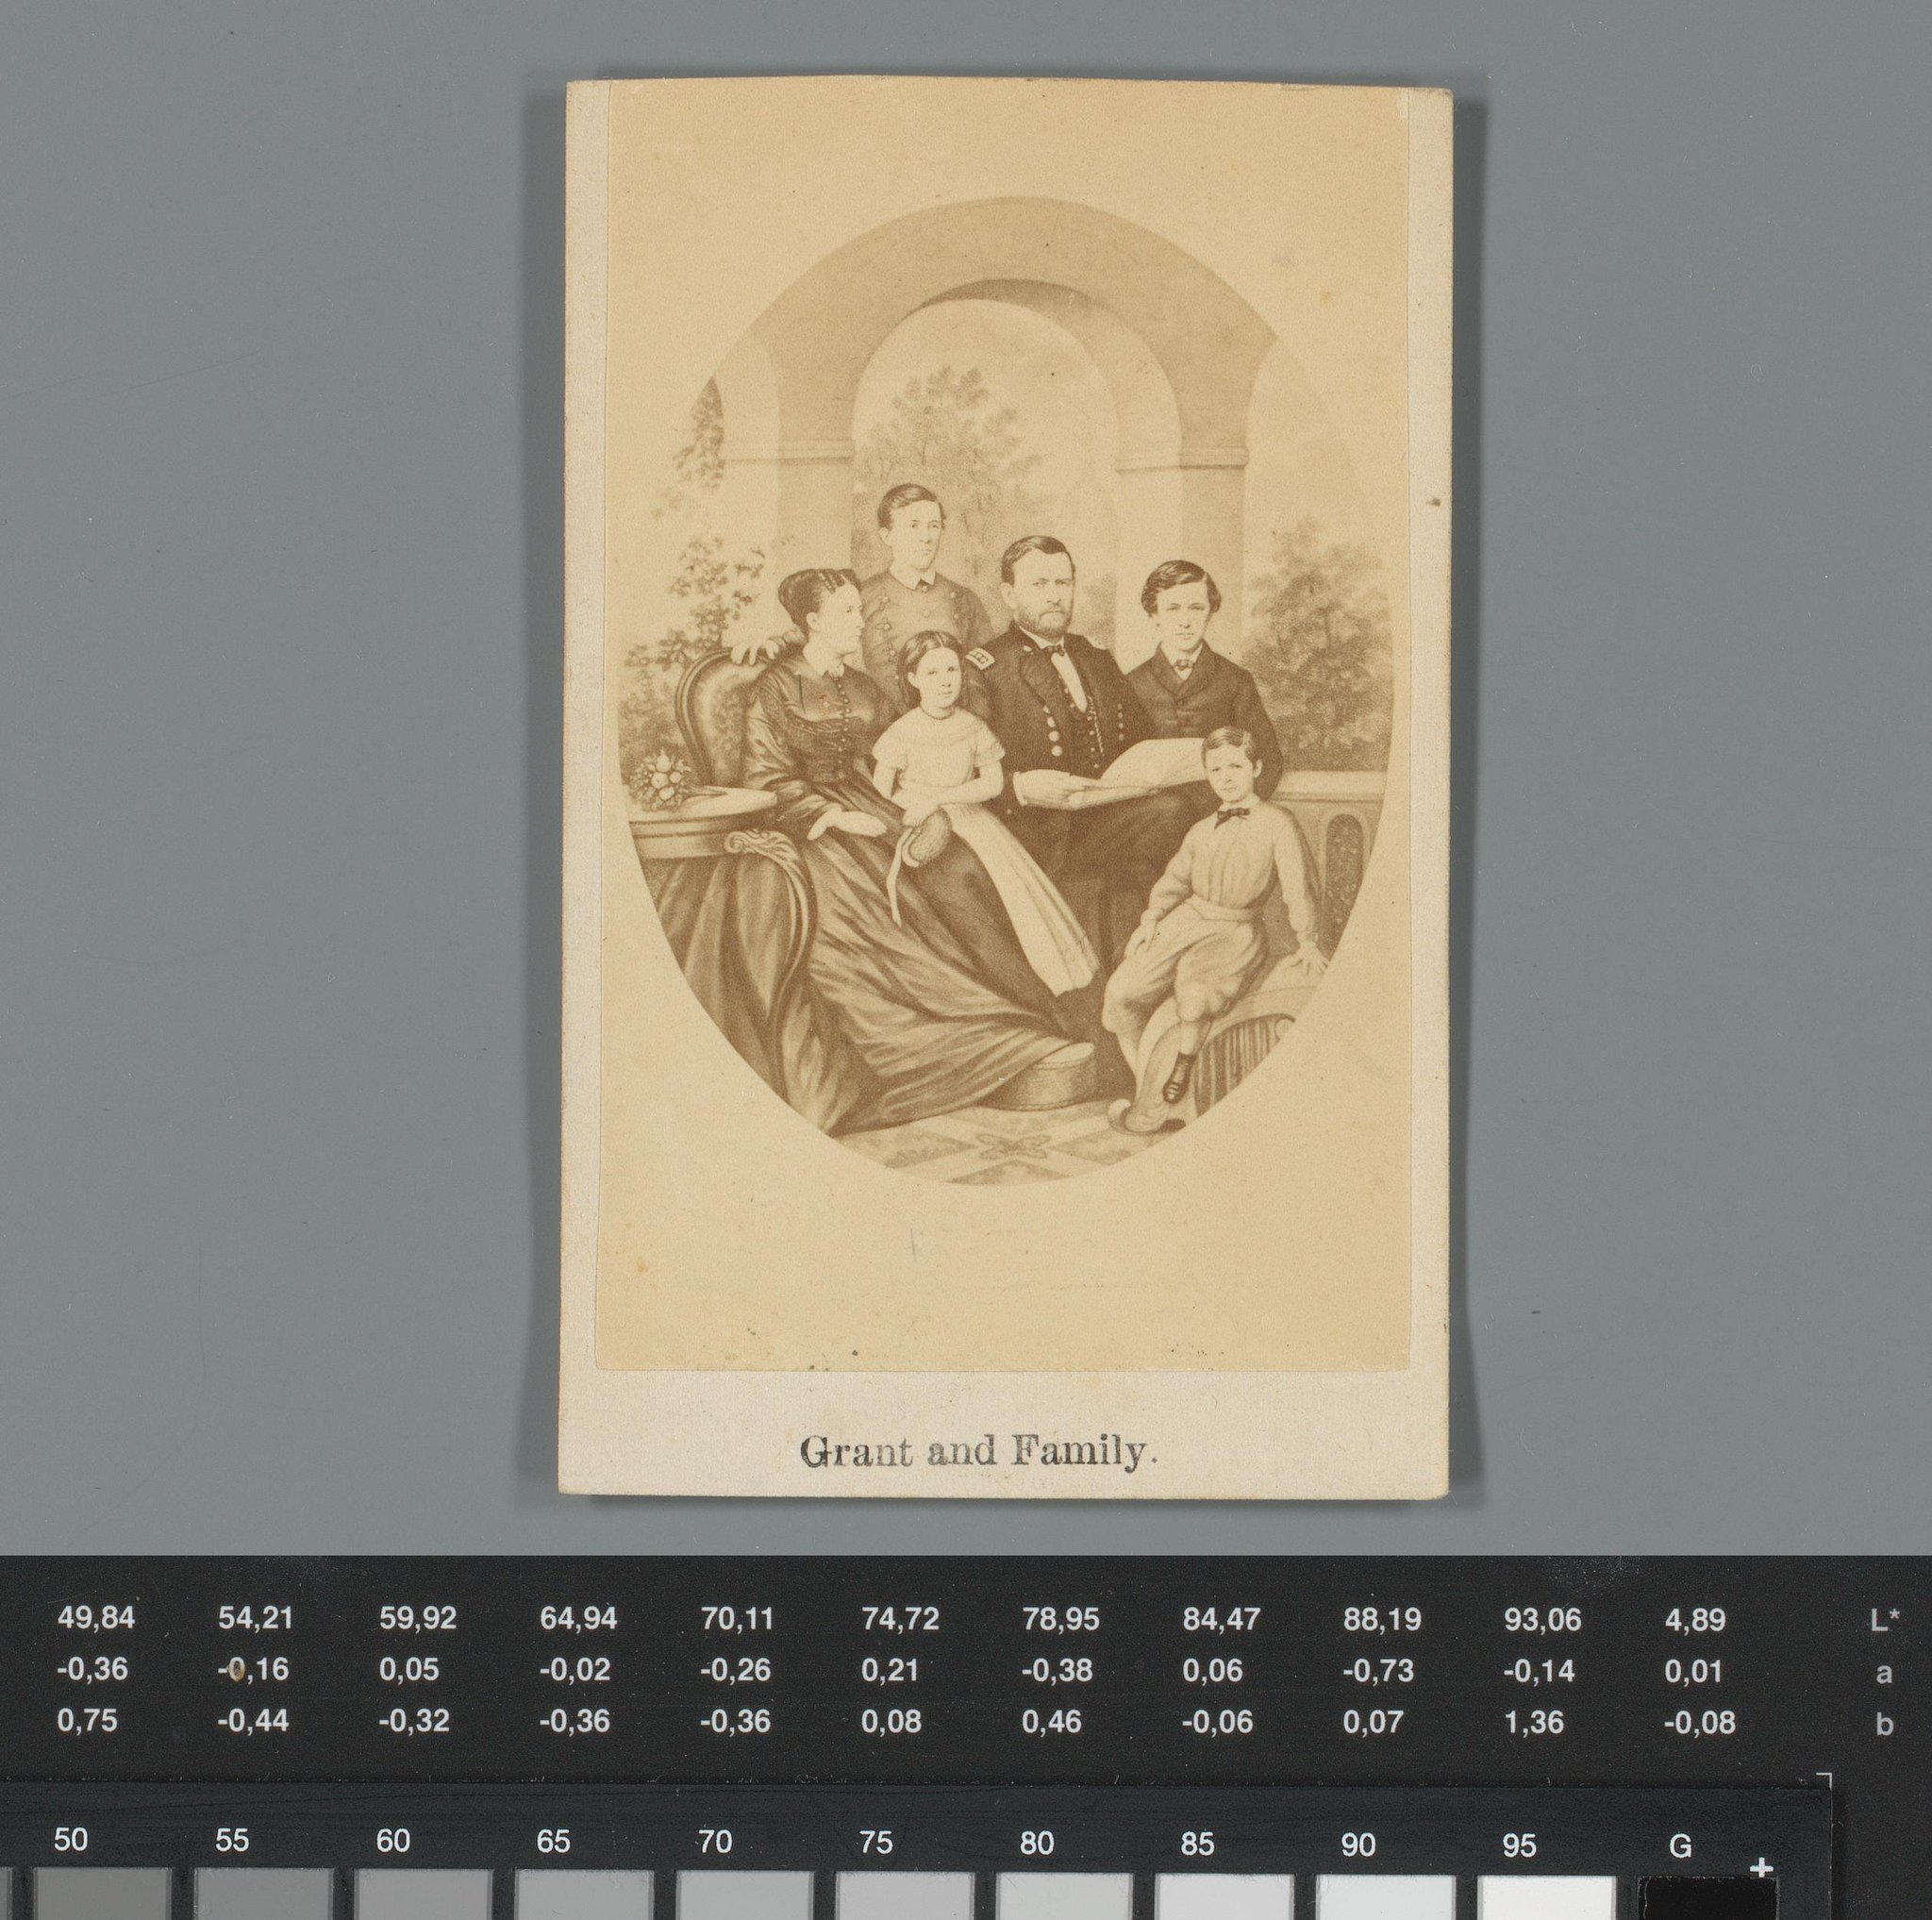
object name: photograph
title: Grant and family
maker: Anonymous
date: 1850-1885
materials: cardboard, photographic support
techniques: albumen print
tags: advertising, family of a ruler, and court, president ~ head of republic, historical persons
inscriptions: inscription: ‘(...)’